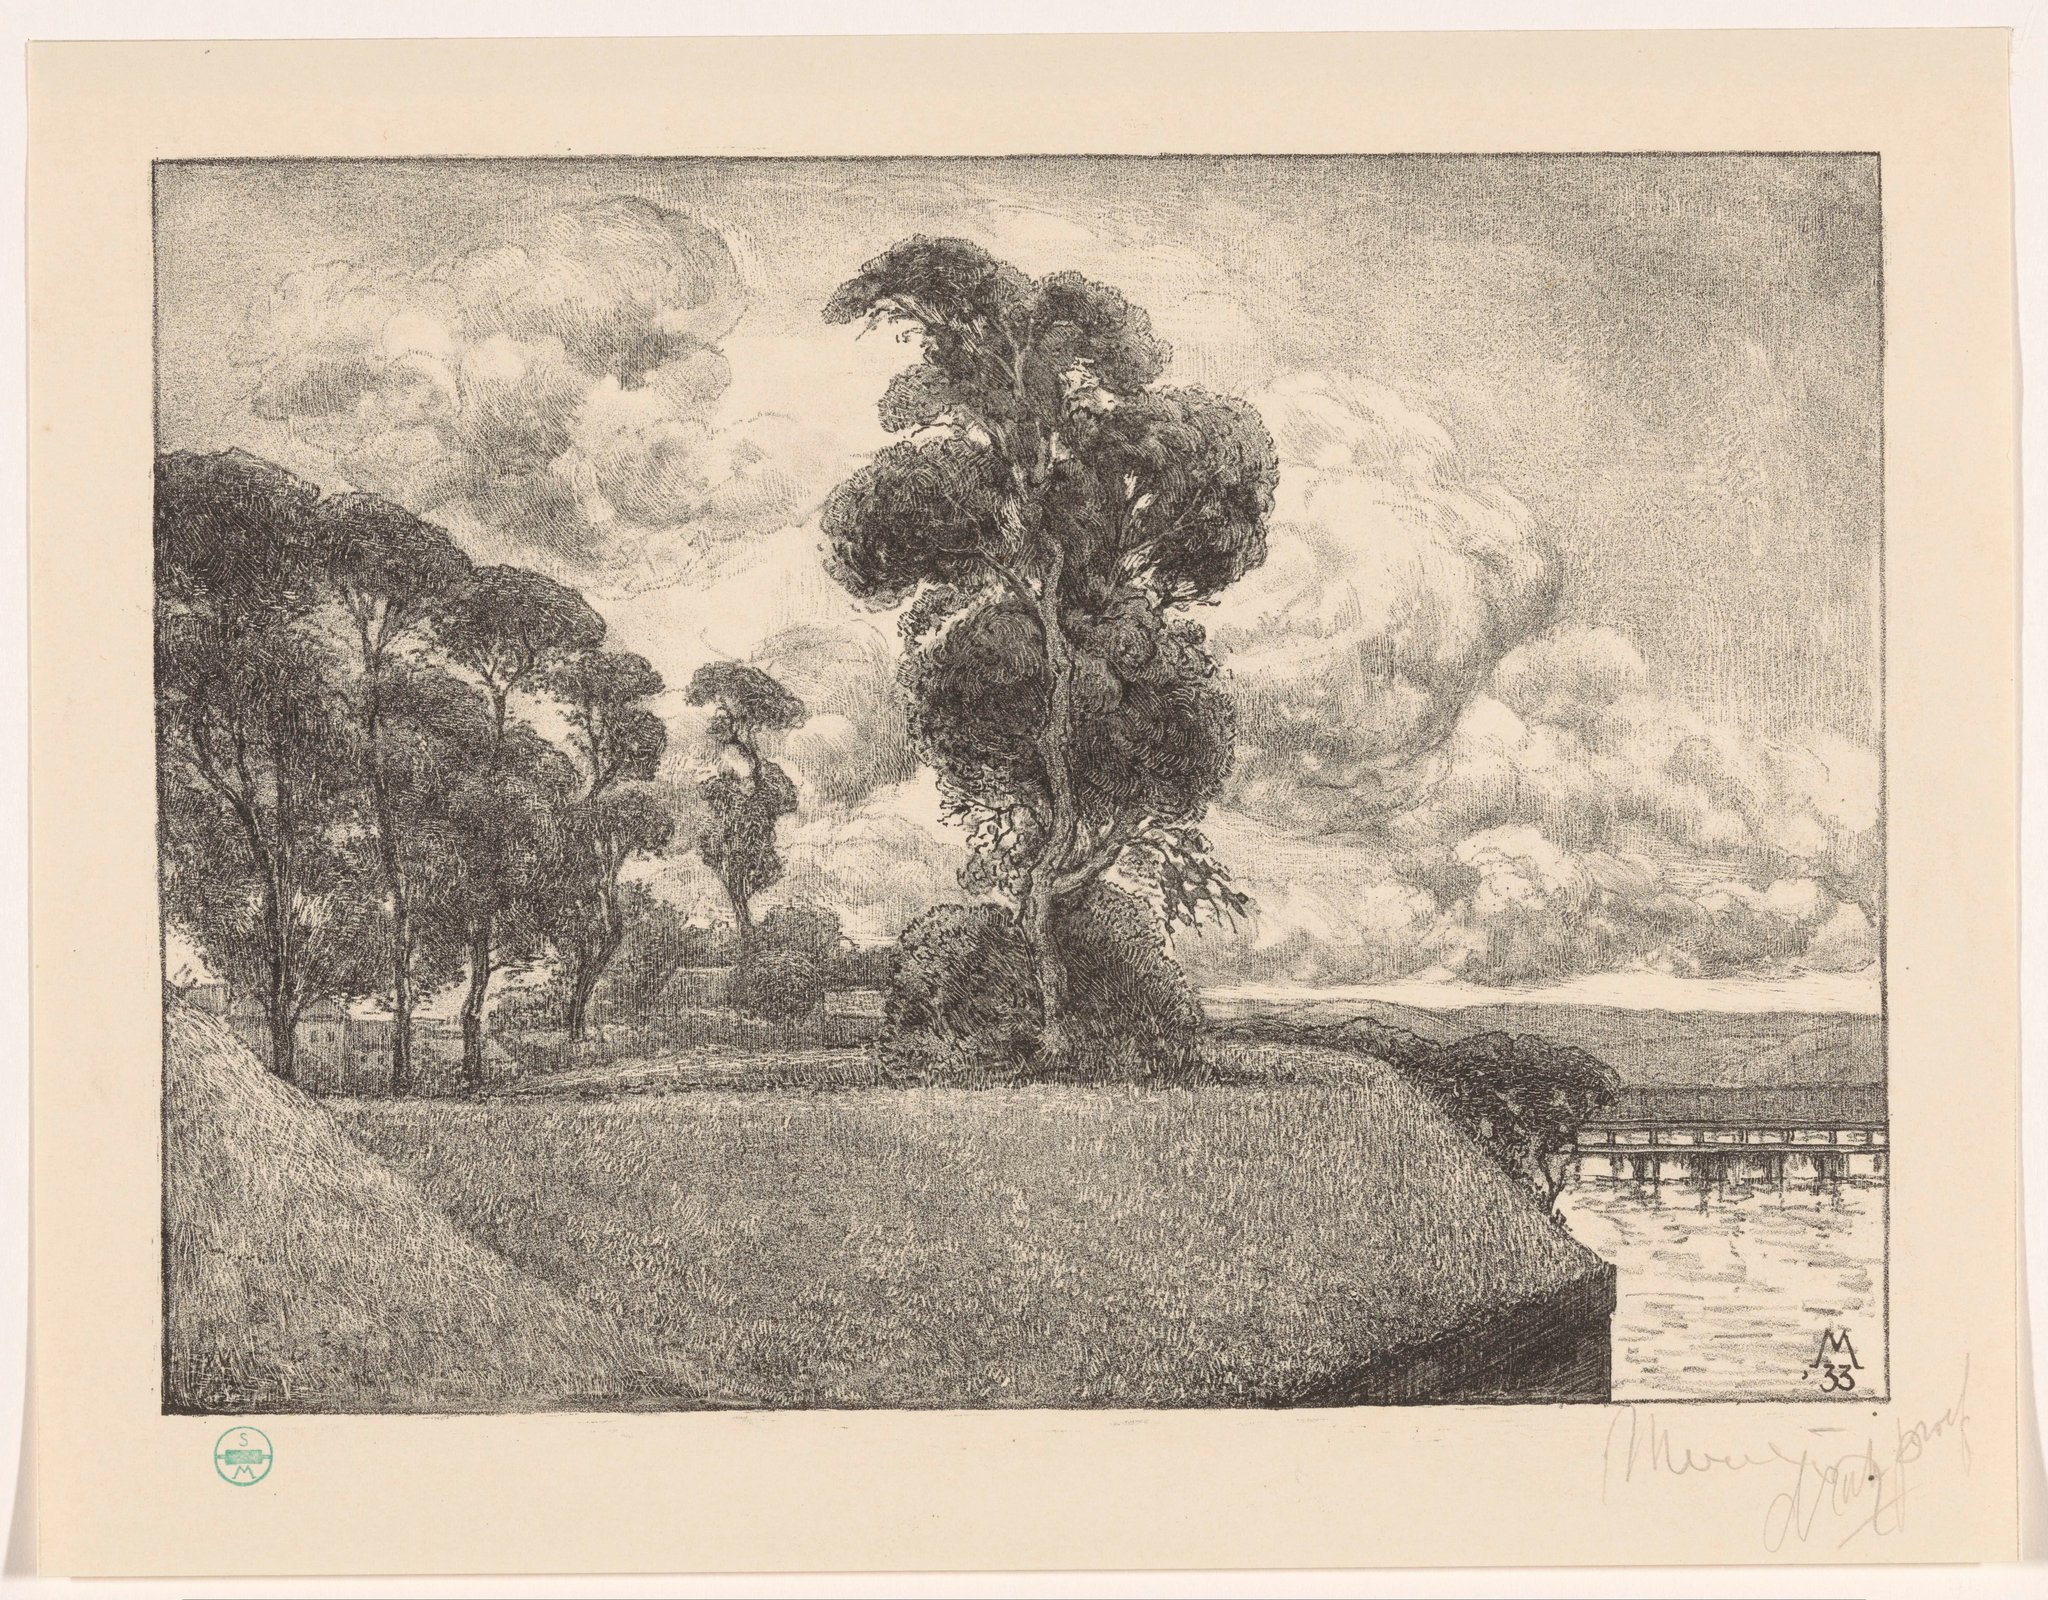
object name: print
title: De wallen van Naarden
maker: simon moulijn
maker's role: draughtsman, print maker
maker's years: 1866-1948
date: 1933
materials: paper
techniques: lithograph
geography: the hague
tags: defence of fortification or city, bastion, bulwark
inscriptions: stamp: Lugt 2362b, collector's mark: Lugt 2228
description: Prent gebruikt voor: Moulijn, Simon. De wallen van Naarden. 's-Gravenhage: Stichting Menno van Coehoorn, 1934.